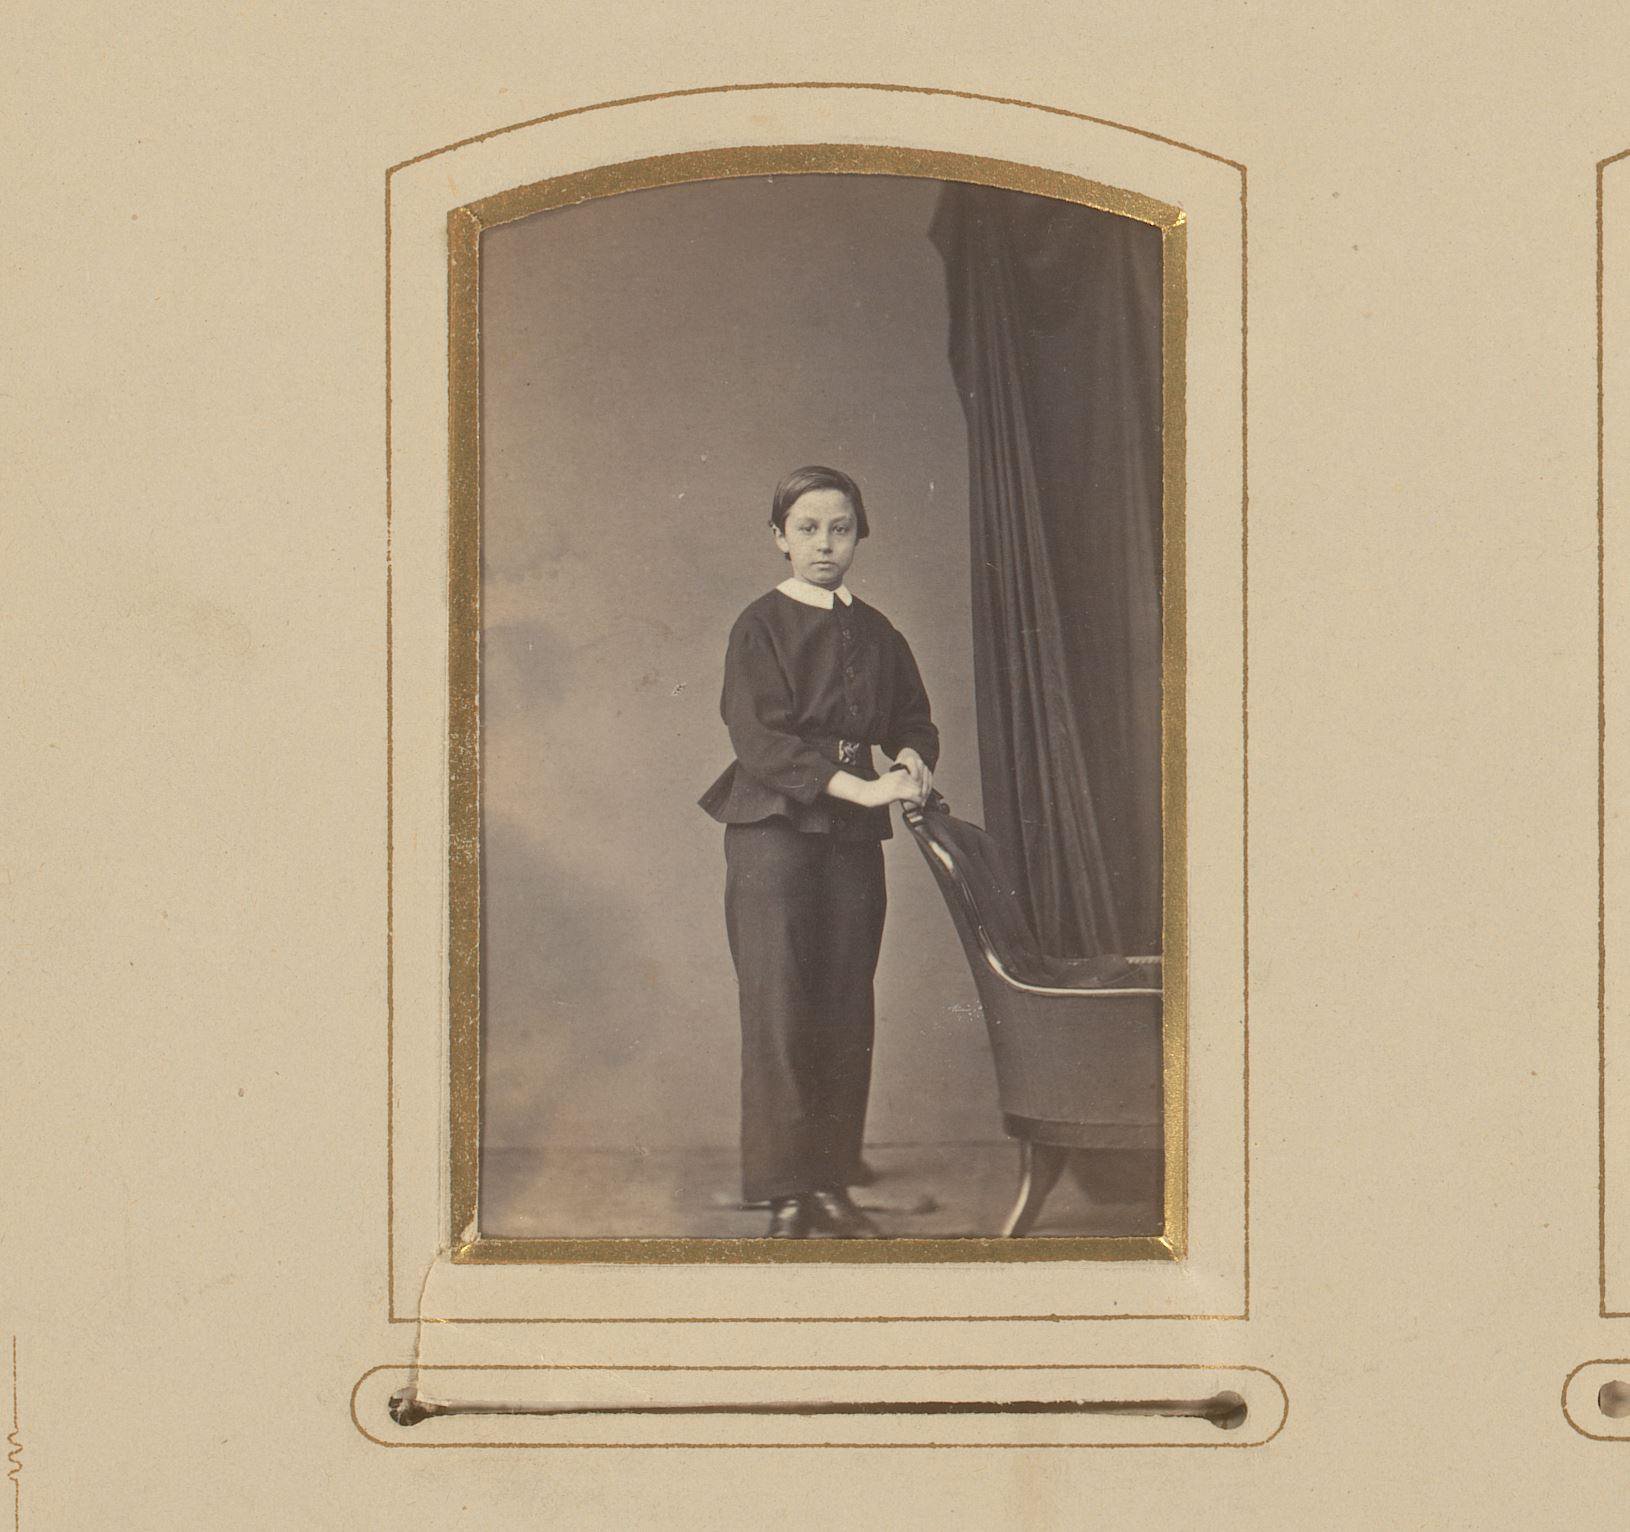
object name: photograph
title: Portret van een jongen bij een stoel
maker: c. von boeckmann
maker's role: fotograaf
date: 1850-1900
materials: cardboard, photographic support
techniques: albumen print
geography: barmen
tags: boy (child between toddler and youth), historical persons, chair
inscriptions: annotation: ‘H’, inscription: ‘Photographie/ von/ C. von BOECKMANN/ in/ BARMEN/ Haspeler Str No 50/ Fortsetzung d. Allee Str.’